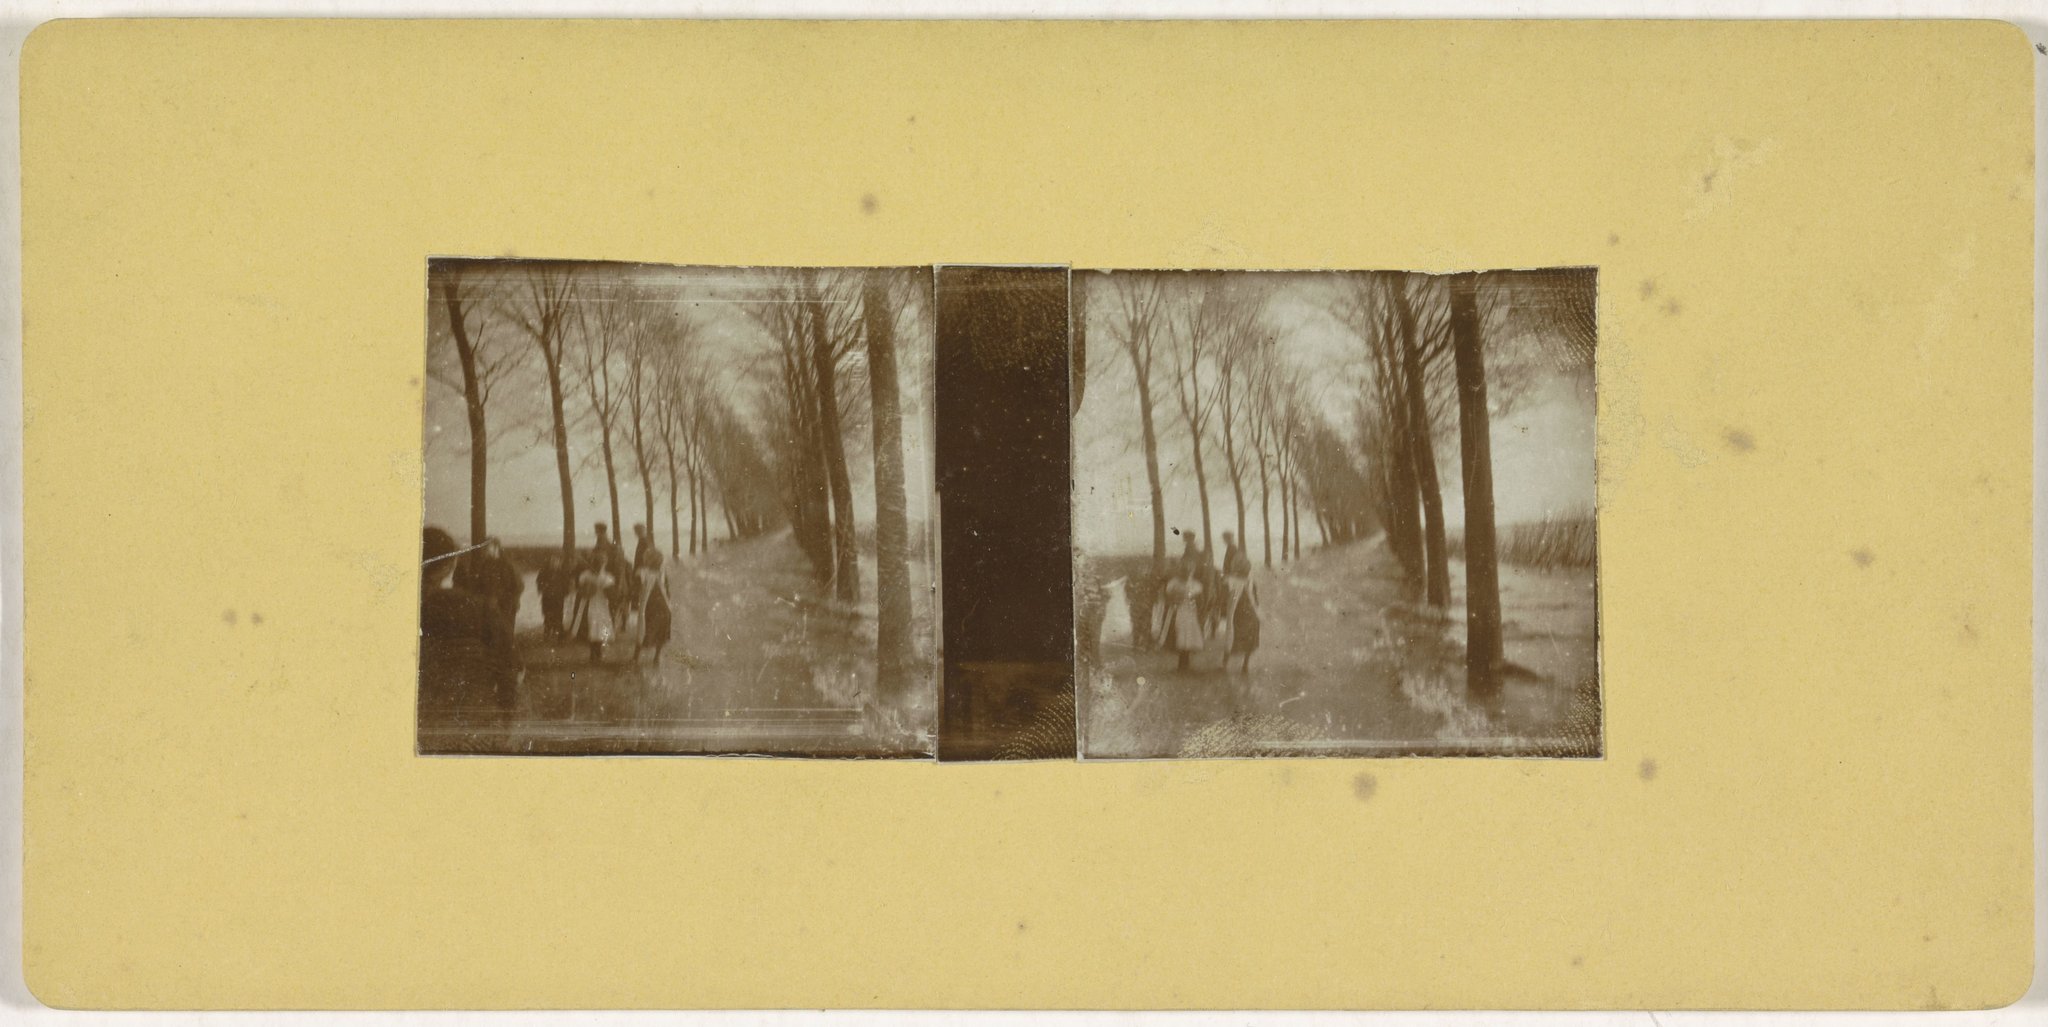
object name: stereograph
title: Mensen wandelend over pad tussen bomen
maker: Anonymous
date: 1860-1920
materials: cardboard, paper, photographic support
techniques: gelatin silver print